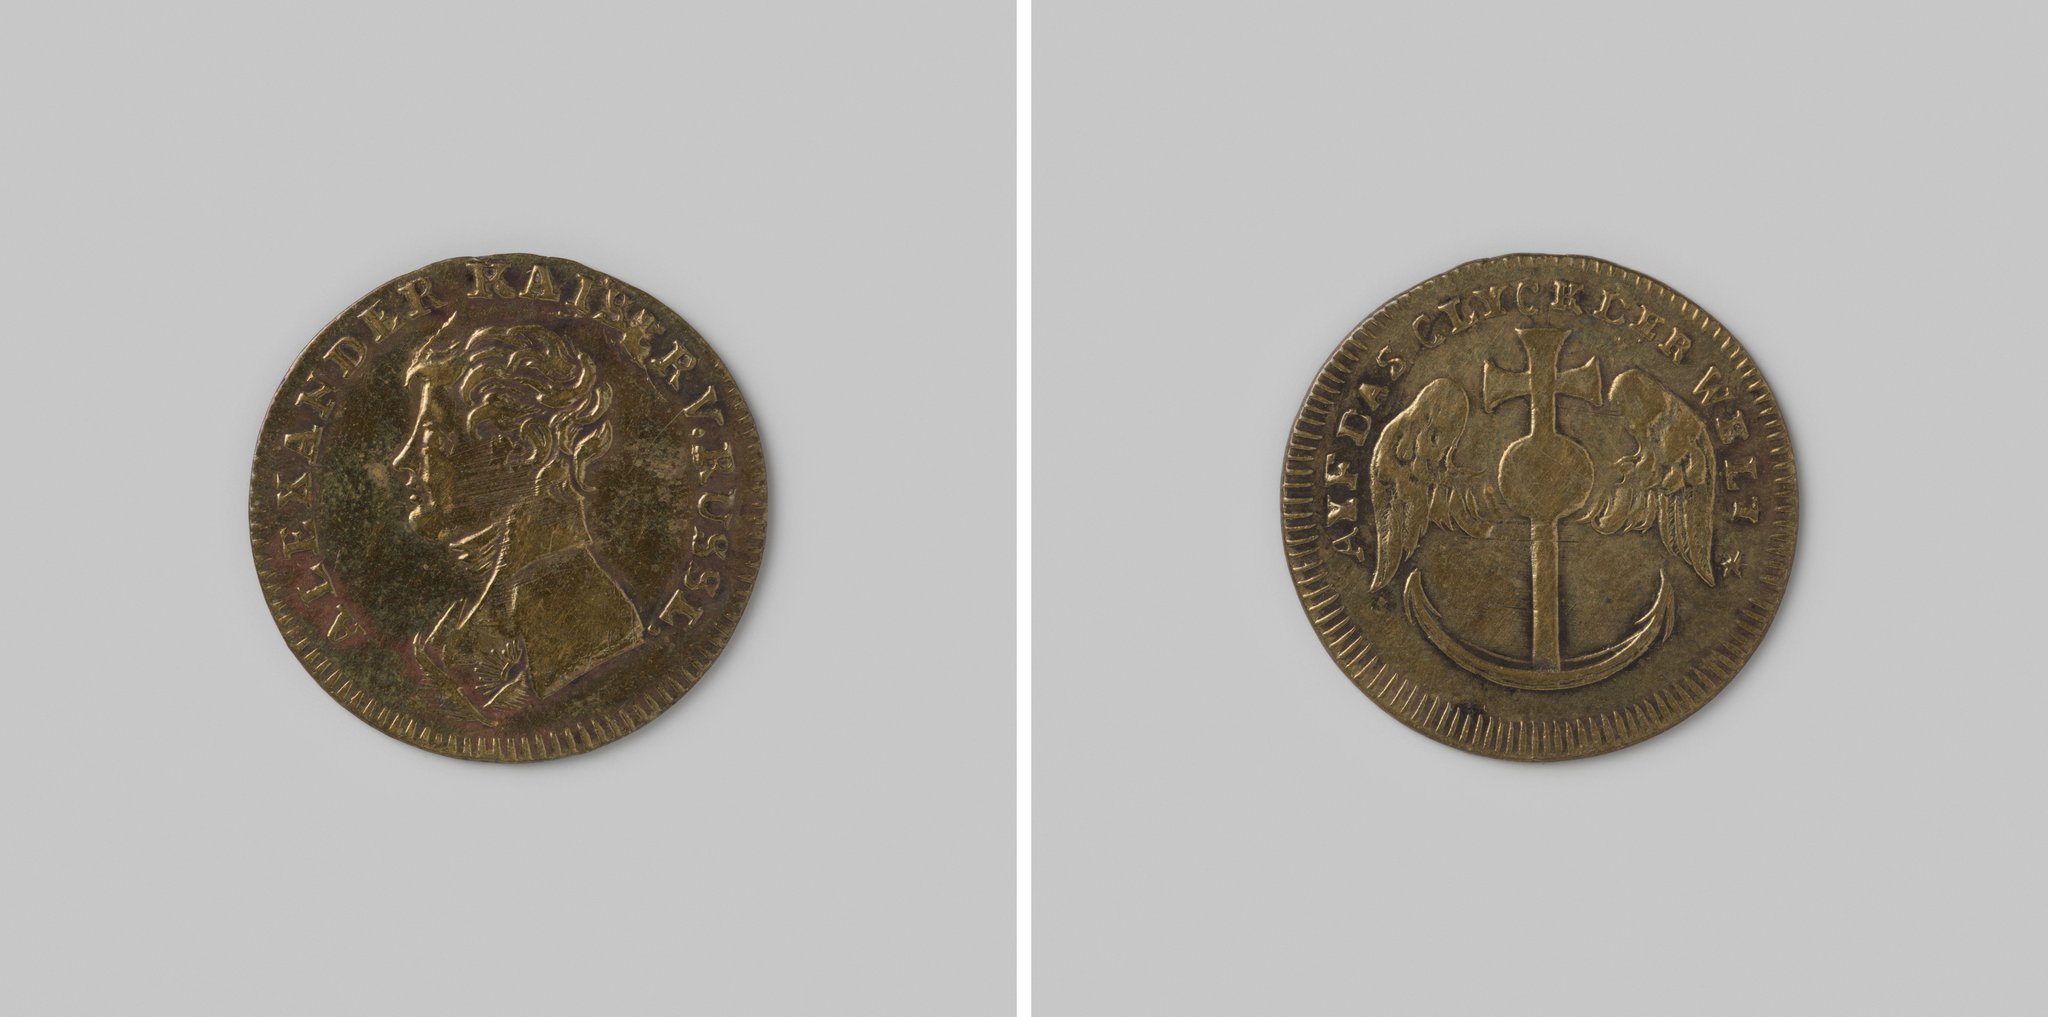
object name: history medal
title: Duitse speelpenning met het portret van Tsaar Alexander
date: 1813-1820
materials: brass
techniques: striking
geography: nuremberg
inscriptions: circumscription: ‘ALEXANDER KAISER V. RUSSL.’, circumscription: ‘AVF GLYCK DER WELT’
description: Messing penning, op de voorzijde het portret van Alexander naar links met omschrift, op de keerzijde een gevleugelde globe op een anker met kruisvormig uiteinde, met omschrift.